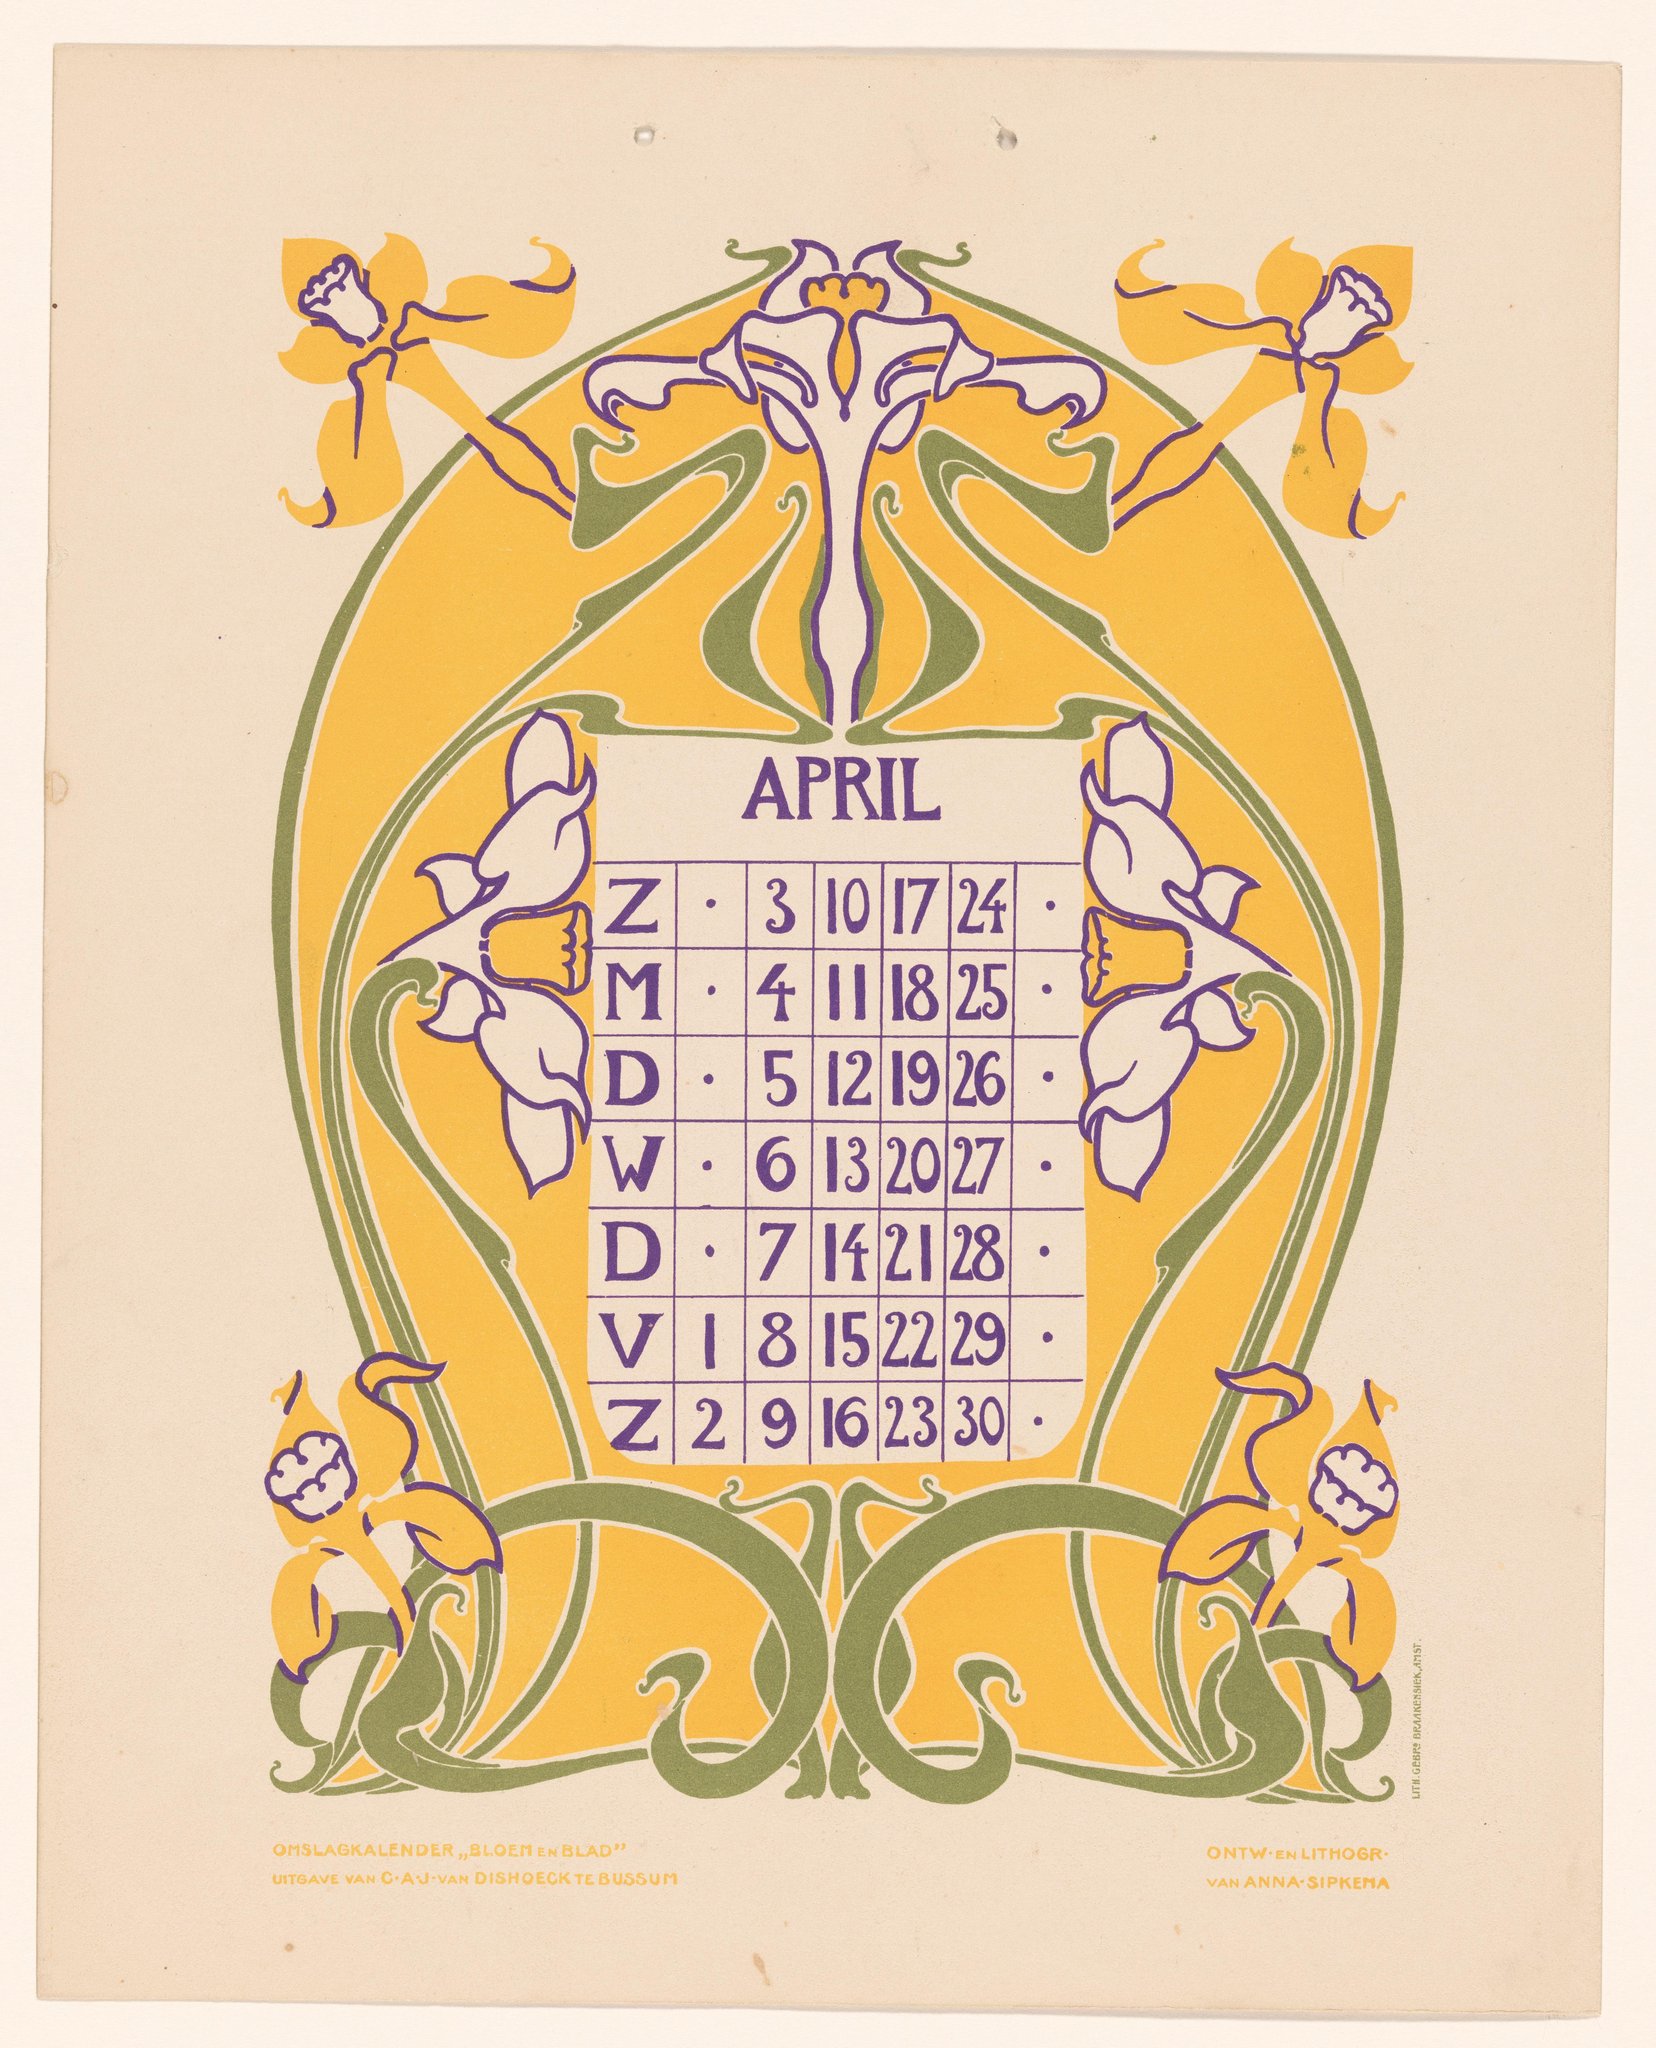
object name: print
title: Omslagkalender "Bloem en blad"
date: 1904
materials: paper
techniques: lithograph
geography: amsterdam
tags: flowers: narcissus, april ~ other concepts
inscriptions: collector's mark: Lugt 2228